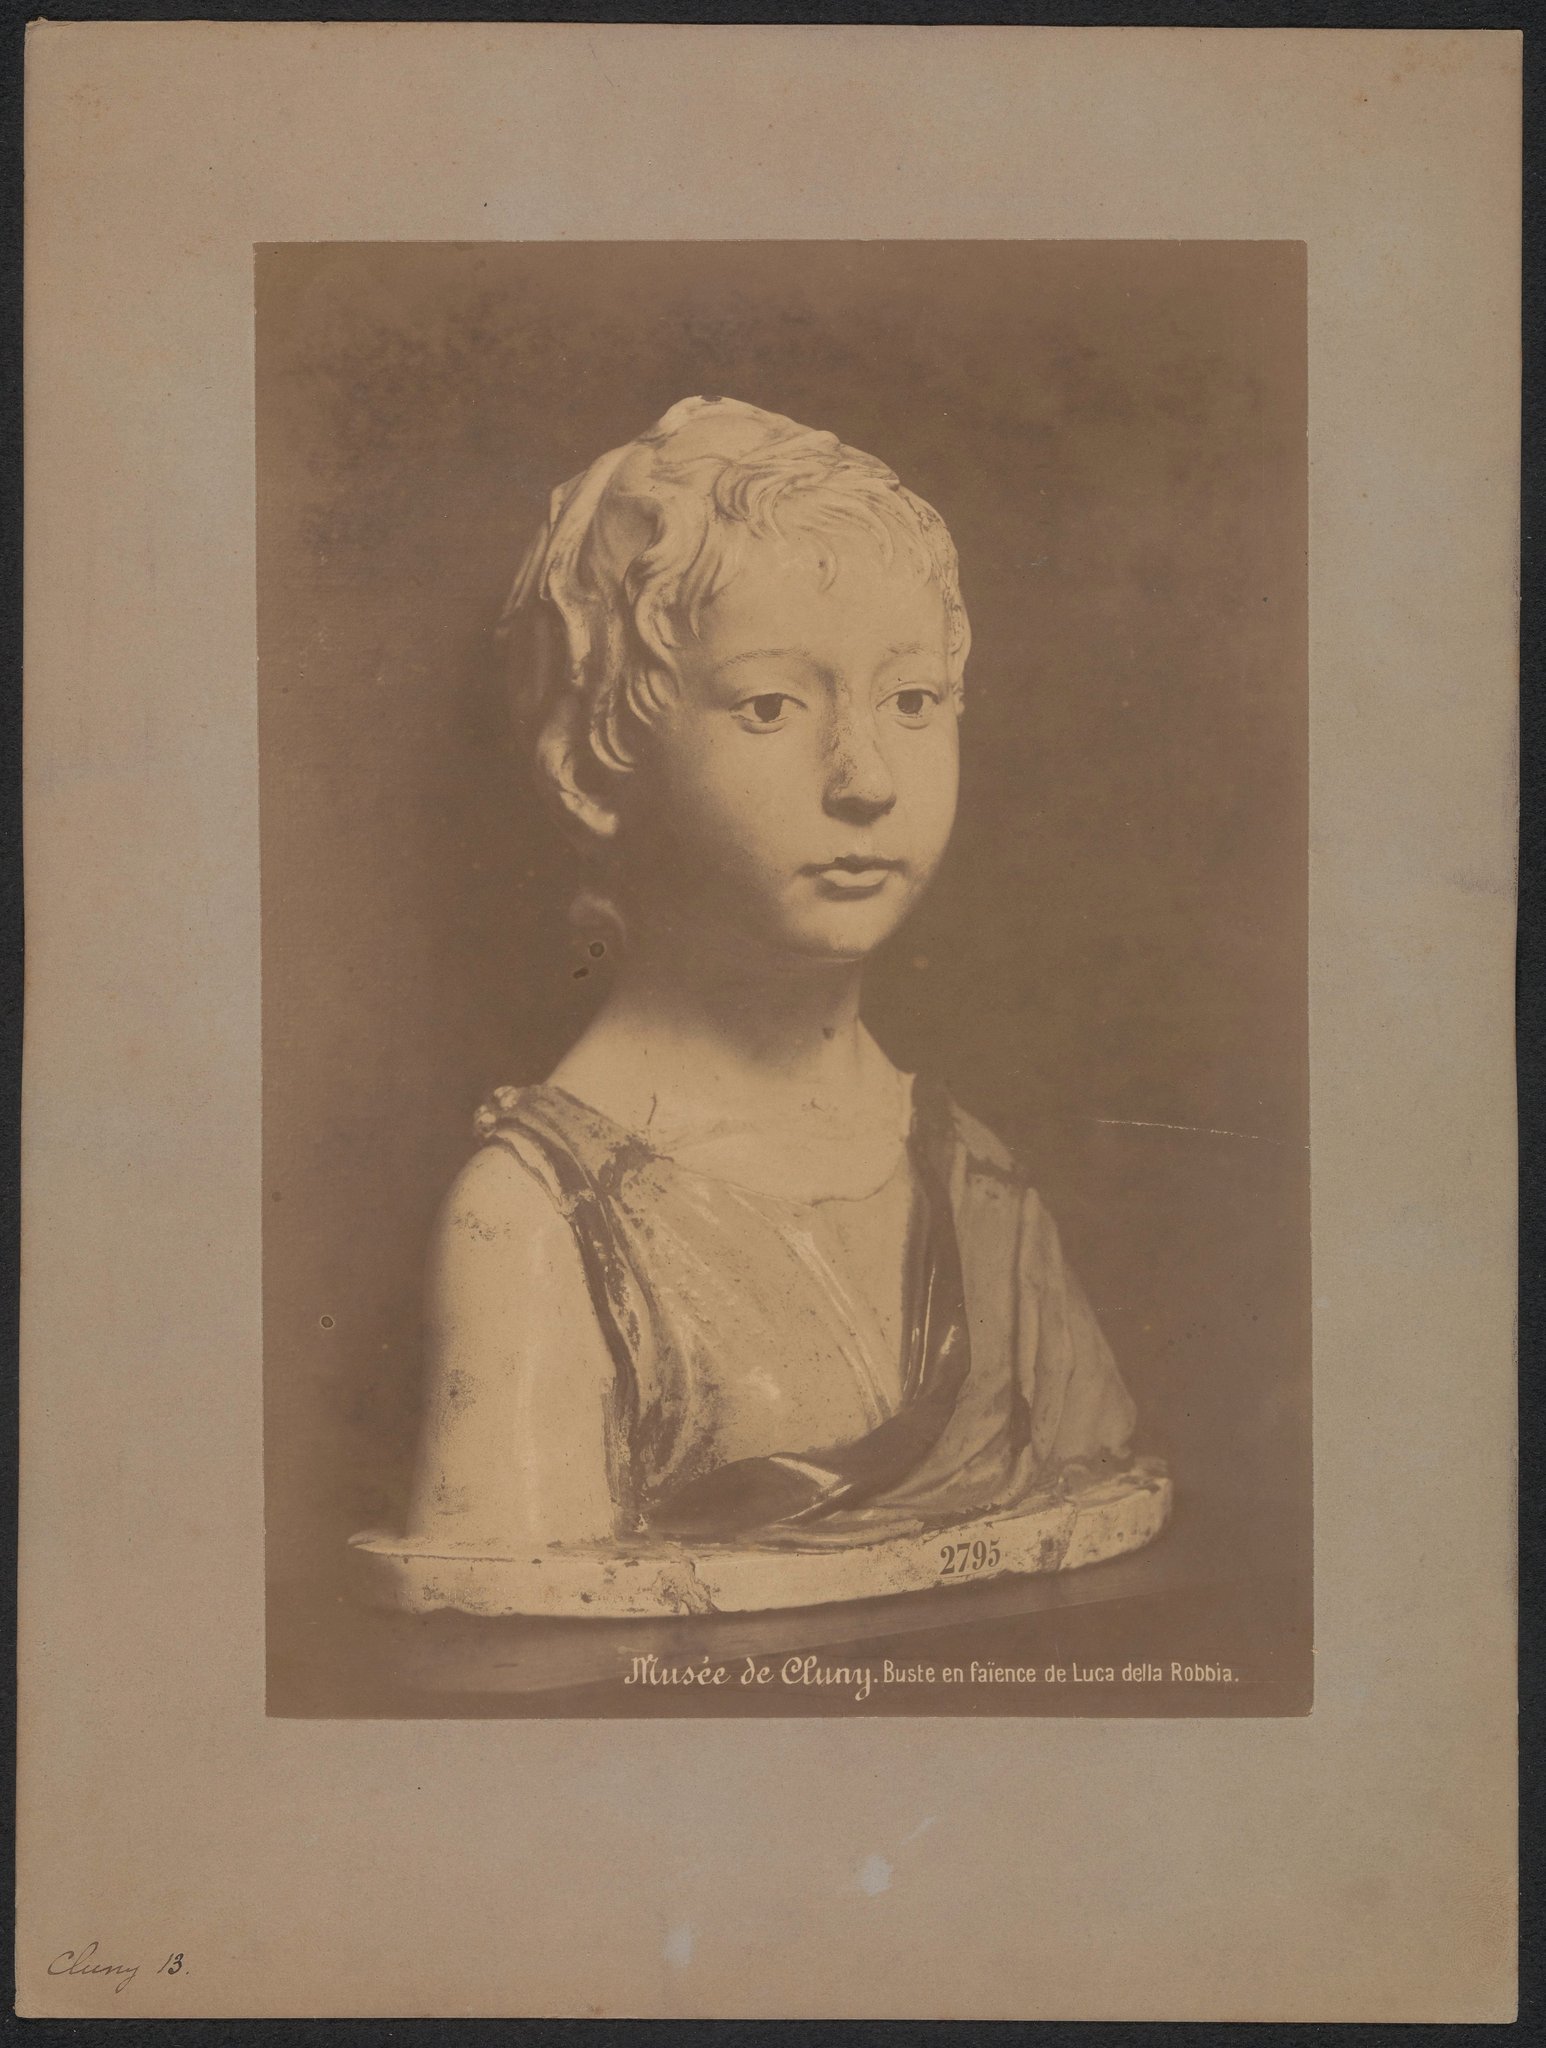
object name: photograph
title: Musée de Cluny. Buste en faïence de Luca della Robbia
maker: séraphin-médéric mieusement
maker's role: fotograaf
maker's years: 1840-1905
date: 1850-1900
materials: cardboard, photographic support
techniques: albumen print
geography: musée de cluny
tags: anonymous historical person portrayed, sculpture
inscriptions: annotation: ‘Cluny 13.’, check stamp: ‘MIEUSEMENT/ PHOTOGRAPHE’, collector's mark: ‘RIJKS NORMAALSCHOOL voor T[EEKENONDERWIJZERS] AMSTERDAM’